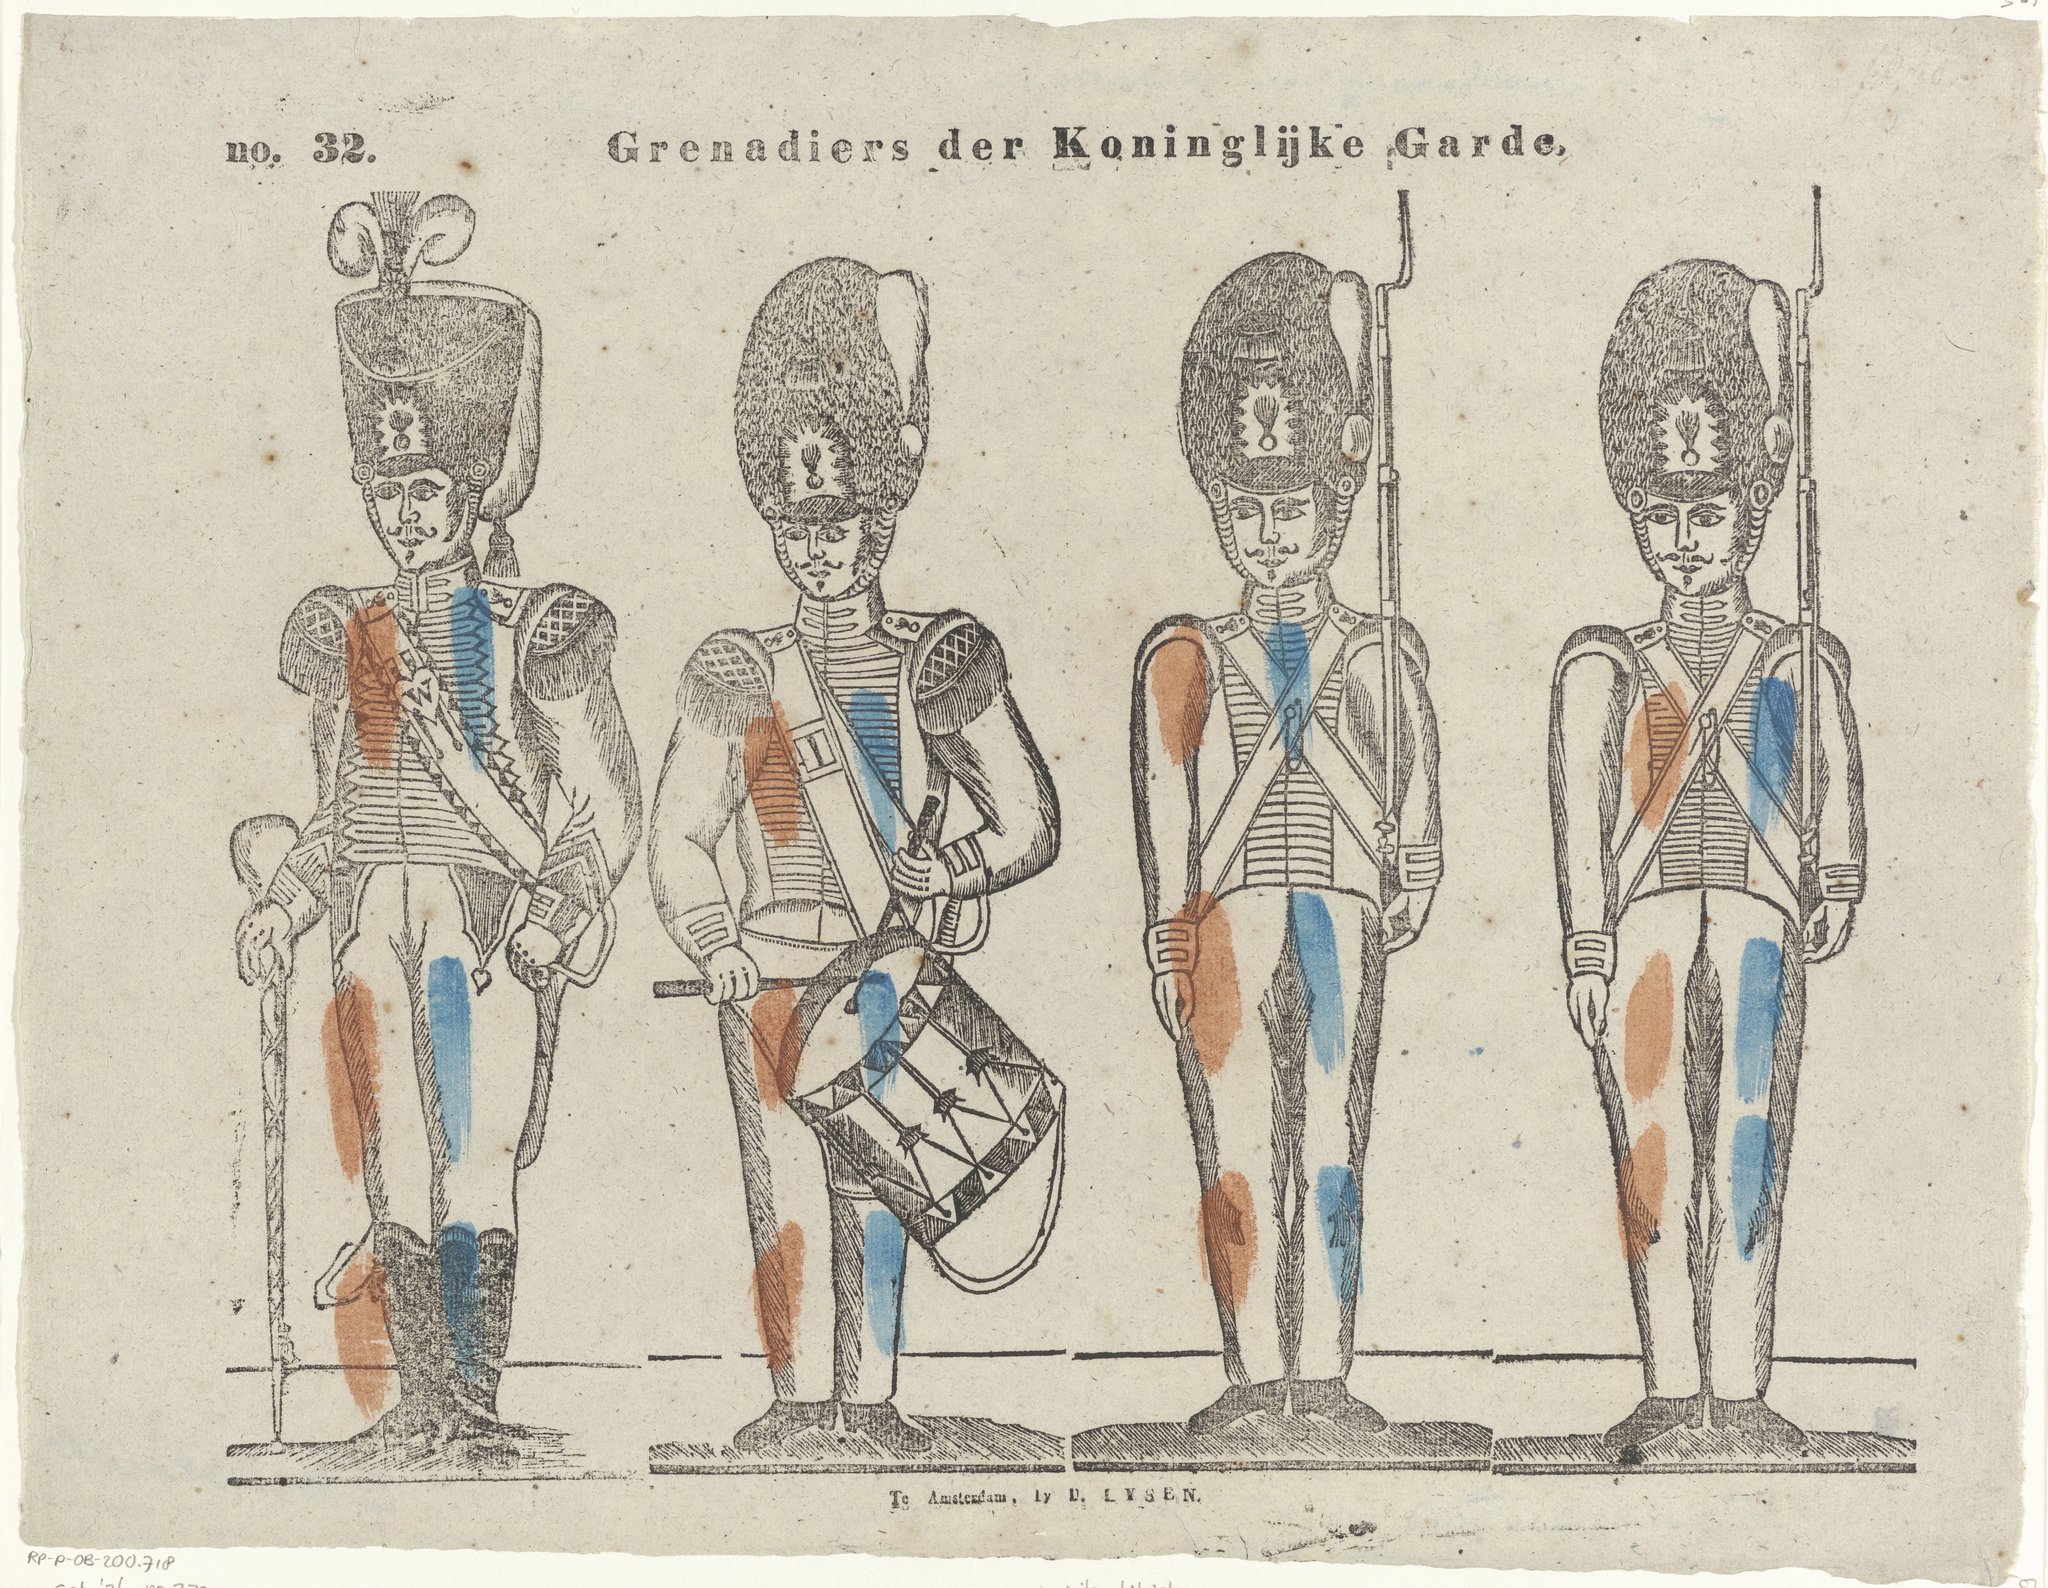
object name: print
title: Grenadiers der koninglijke garde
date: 1836-1849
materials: paper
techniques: colour, letterpress printing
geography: rotterdam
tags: the soldier; the soldier's life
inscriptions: collector's mark: Lugt 2760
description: Blad met 4 voorstellingen van staande militairen. Figuren om uit te knippen, op karton te plakken en aan de voet te verstevigen met een klosje hout om ze overeind te kunnen zetten. Genummerd linksboven: no. 32.